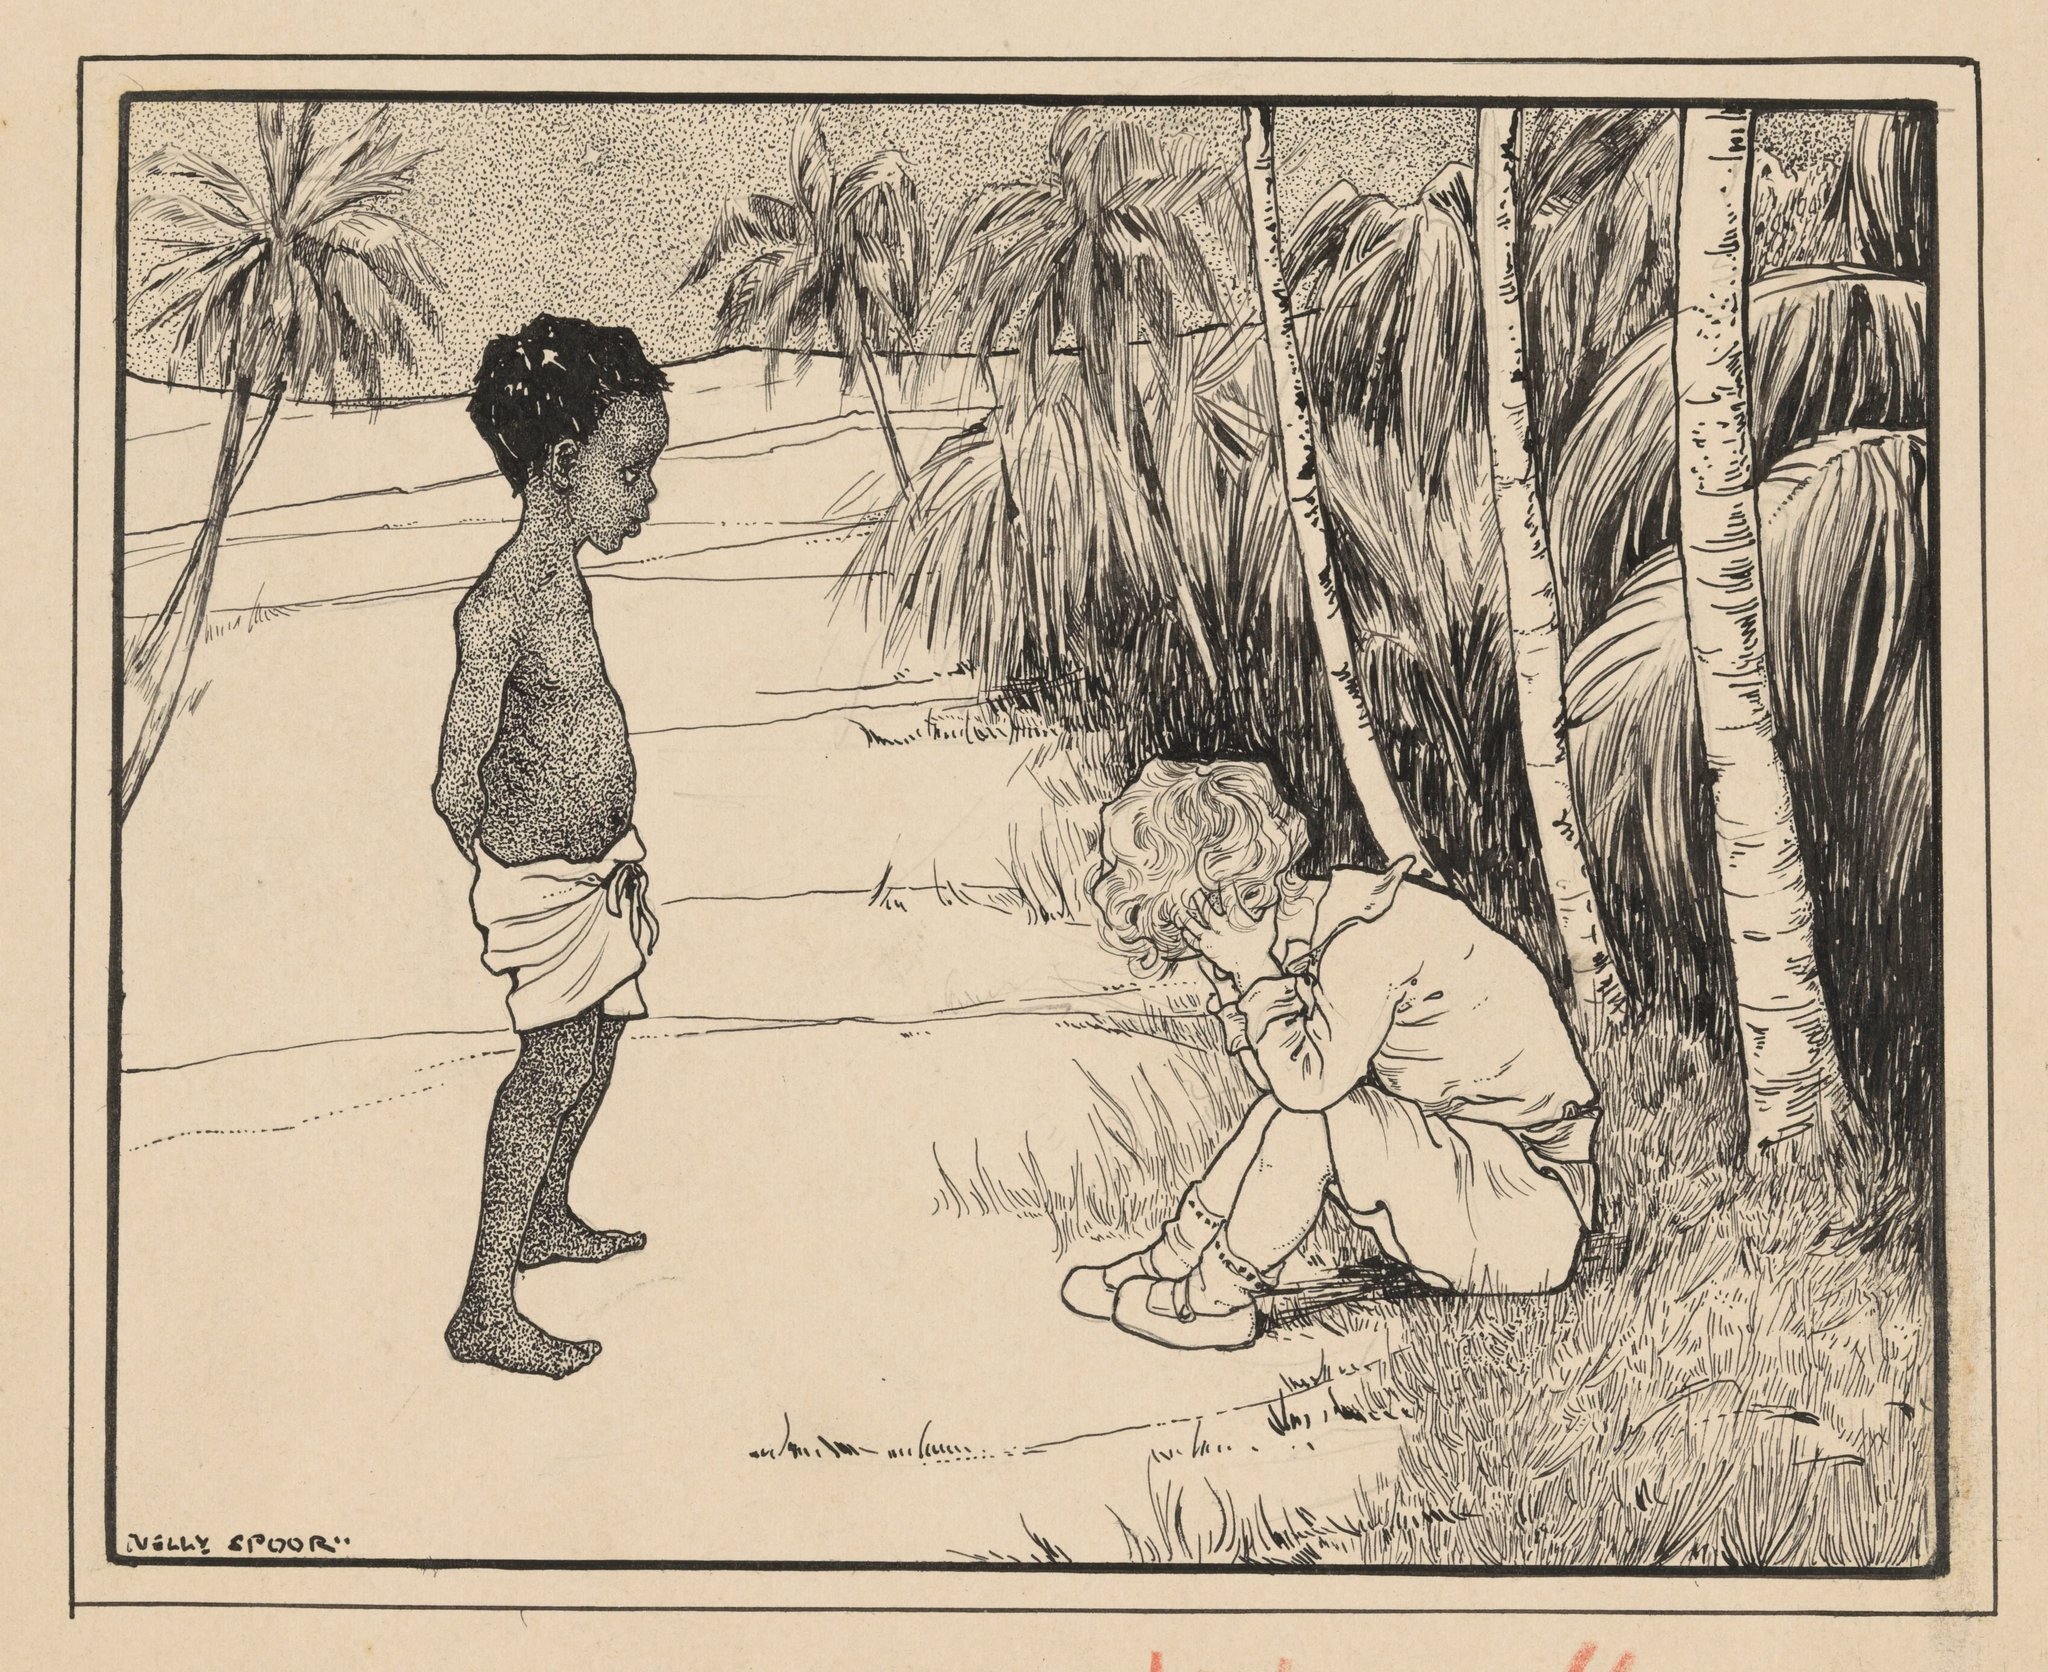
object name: drawing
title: Twee jongens in een woestijnlandschap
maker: nelly spoor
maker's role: draughtsman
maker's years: 1885-1950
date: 1895-1950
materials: cardboard, ink, pencil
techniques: pen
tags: desert (+ landscape (in the non-temperate zone) with figures, staffage), boy (child between toddler and youth), huddled figure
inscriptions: :, collector's mark: Lugt 2228, signature: ‘NELLY SPOOR "’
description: In een woestijnlandschap zit een jongen ineengedoken en met de handen in het haar op de grond naast een rij bomen en planten. Een jongen gekleed in een lendendoek staat voor hem en kijkt naar hem.